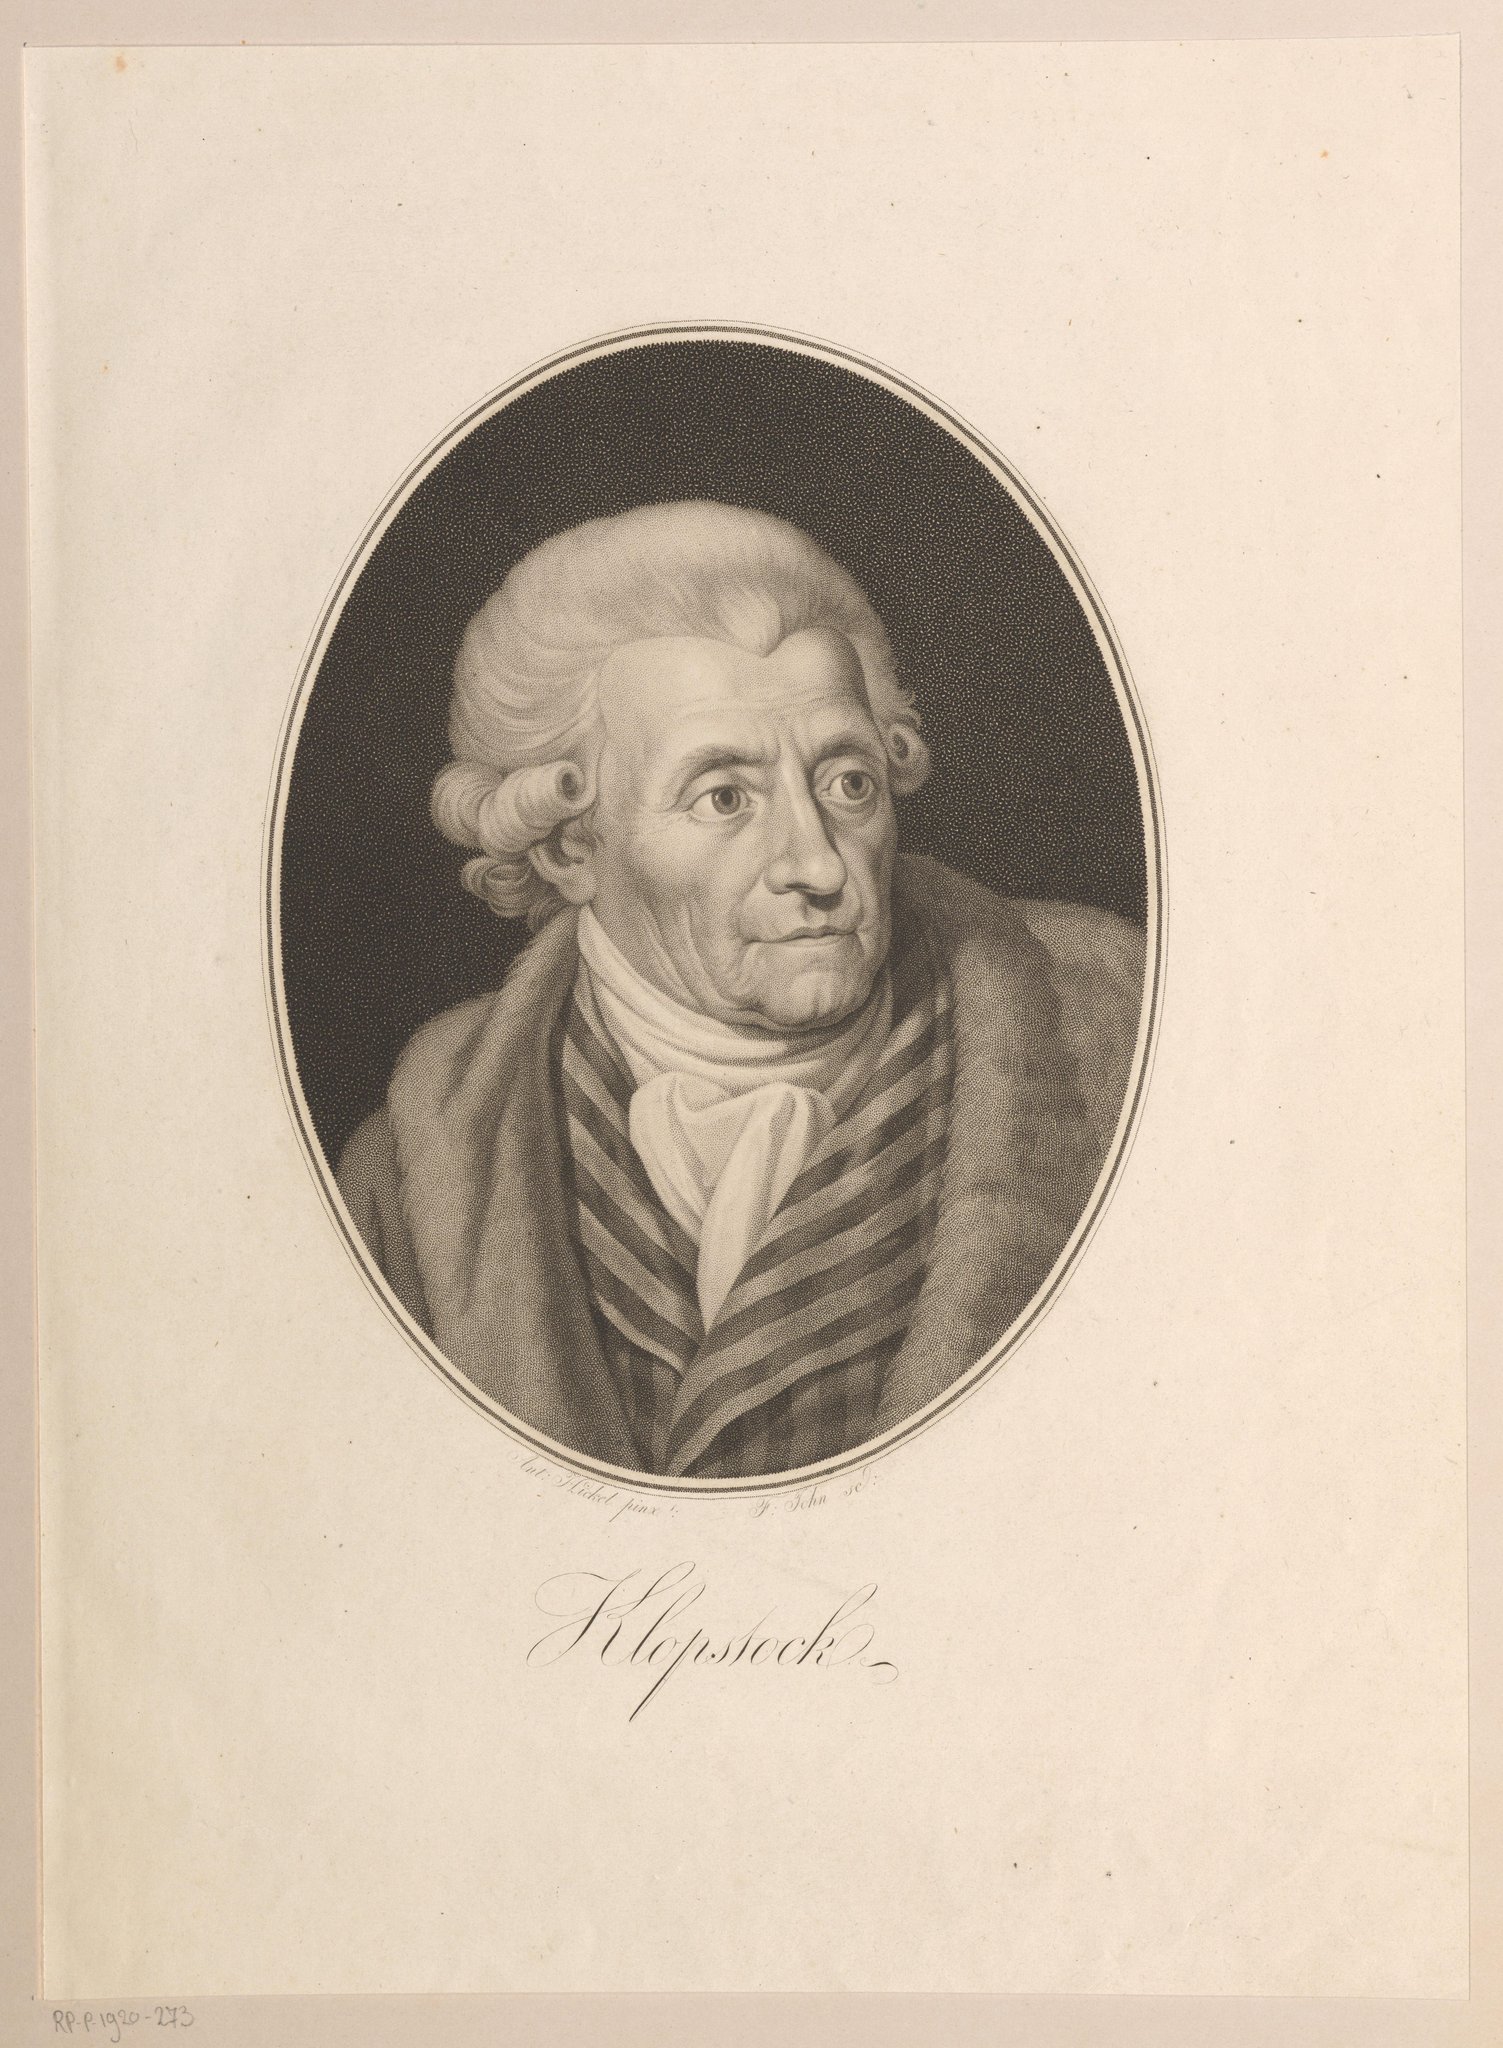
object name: print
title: Portret van Friedrich Gottlieb Klopstock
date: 1779-1843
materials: paper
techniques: engraving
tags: historical persons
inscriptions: collector's mark: Lugt 2228